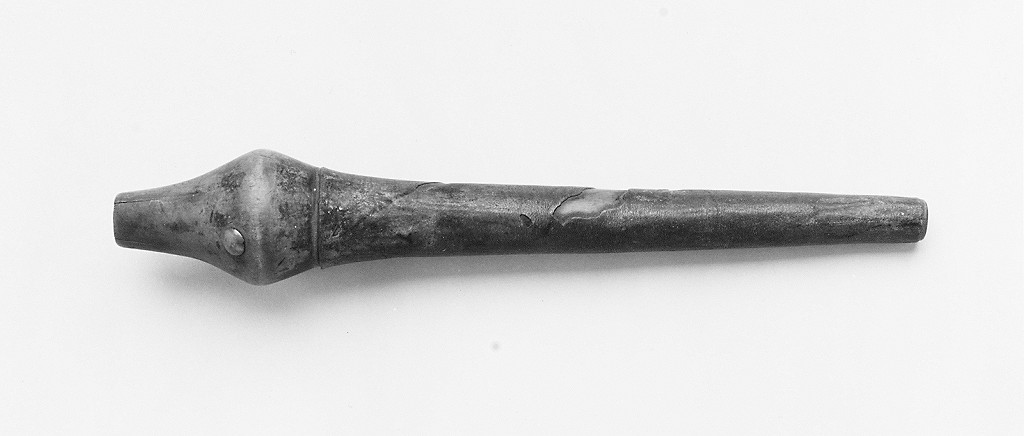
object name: whistle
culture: african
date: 1867-1900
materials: wood